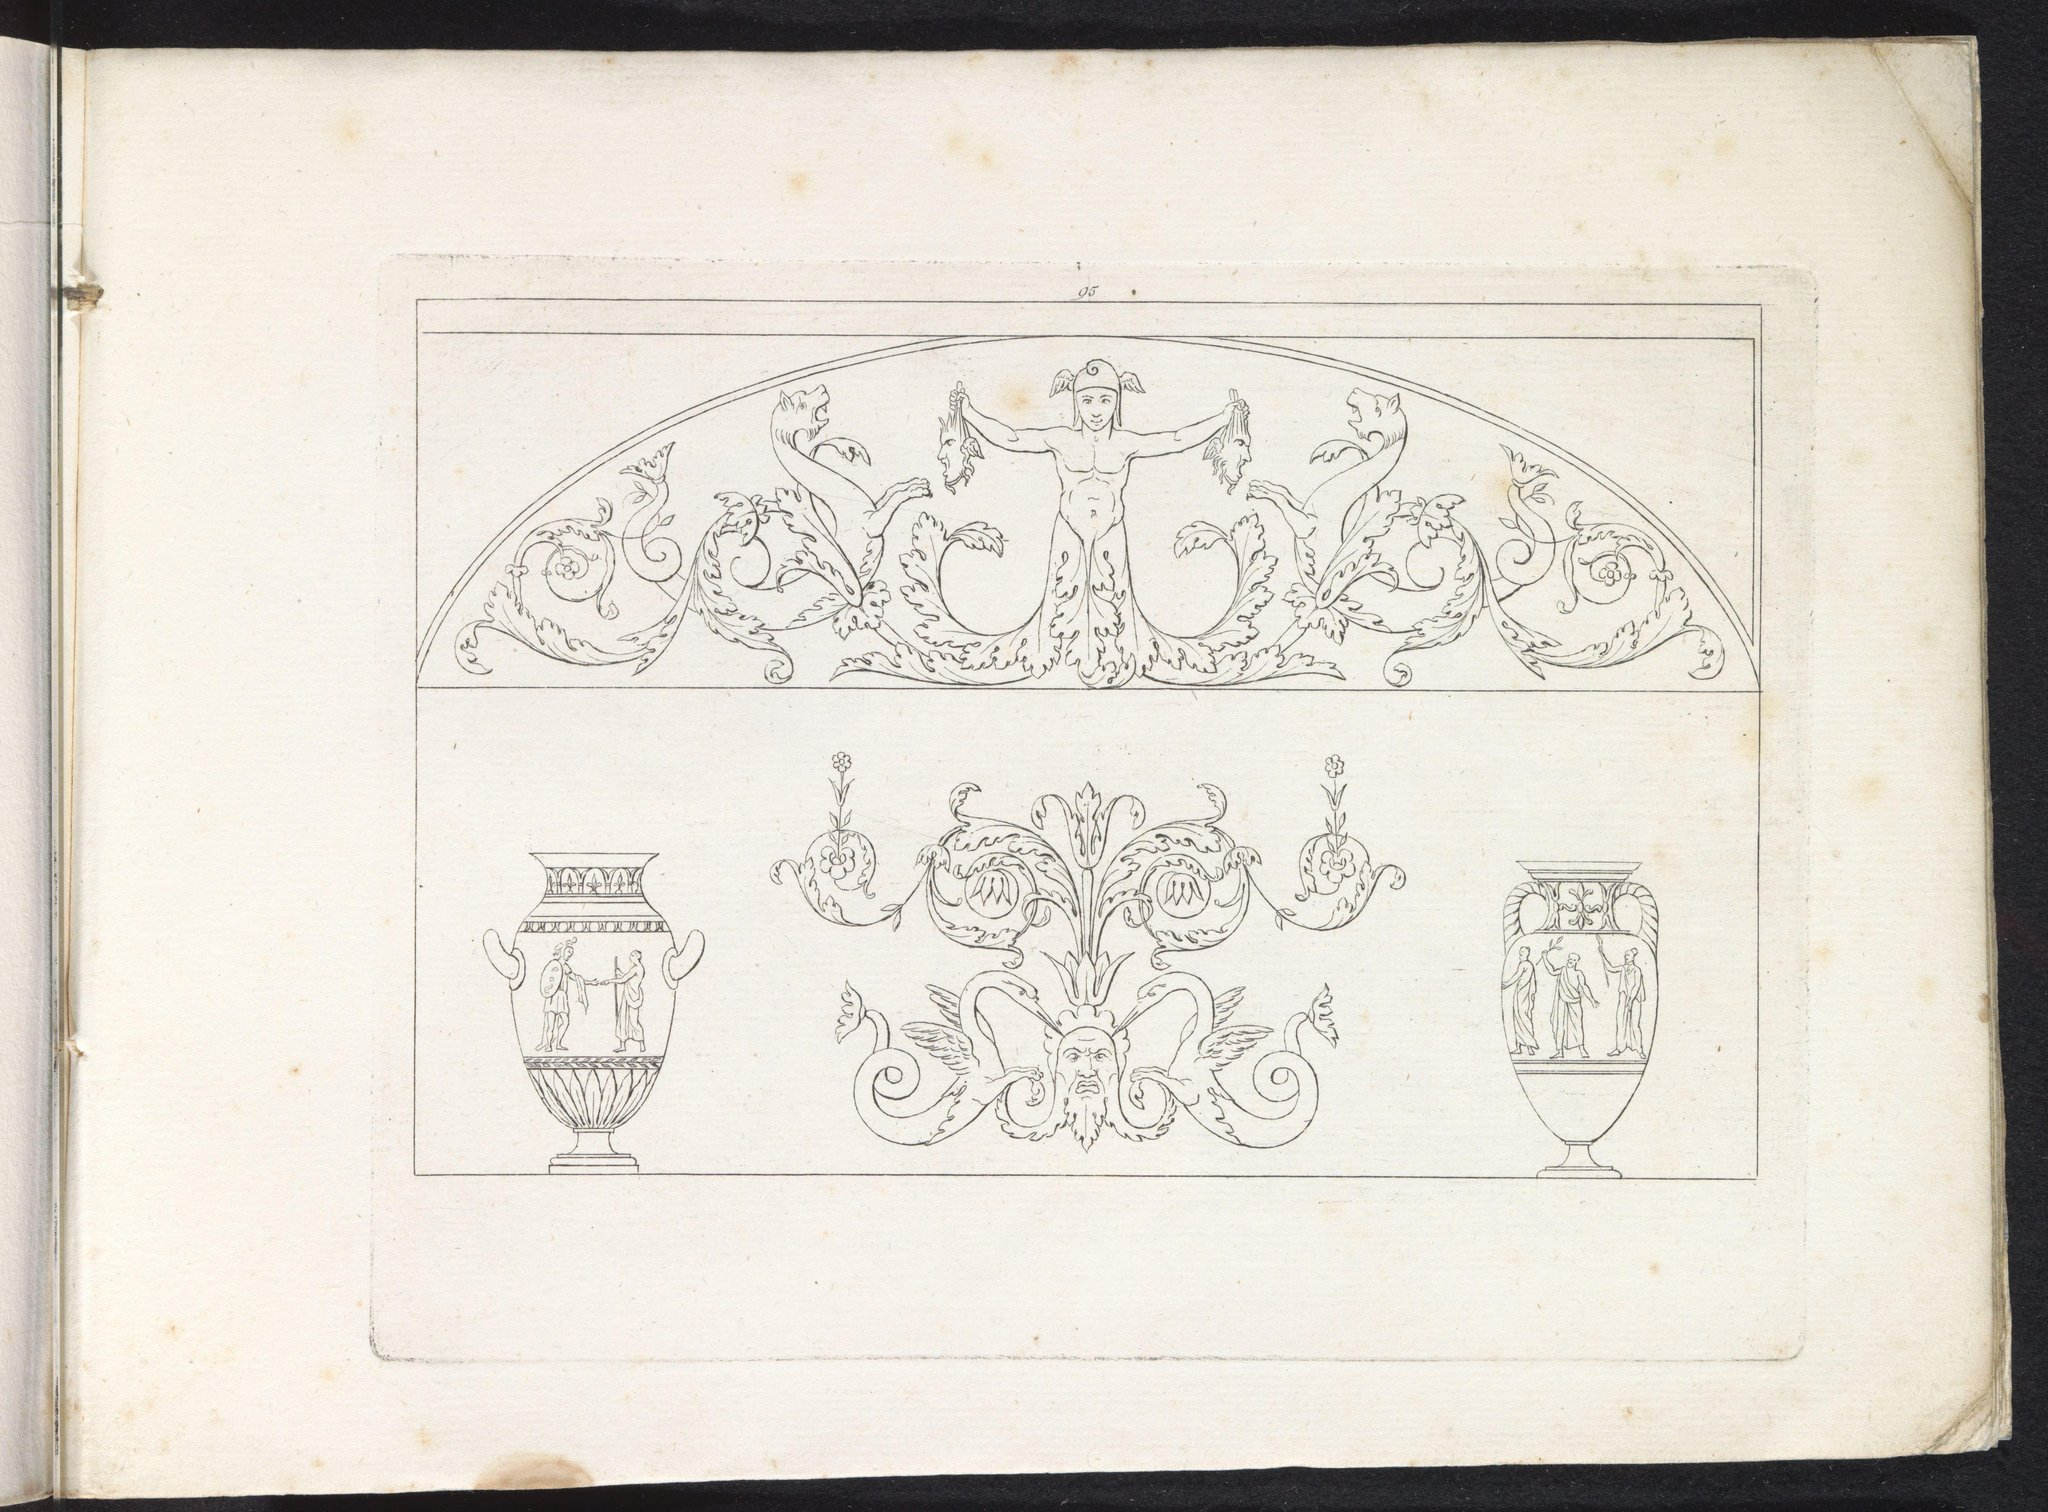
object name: ornament print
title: Ontwerpen voor religieuze en profane voorwerpen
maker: pietro ruga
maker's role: print maker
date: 1817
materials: paper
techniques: etching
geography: italy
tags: ornaments ~ art, ornament ~ arabesque, vase ~ ornament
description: Prent maakt deel uit van een reeks van 100 prenten (+ titelprent) met ontwerpen voor religieuze en profane voorwerpen.